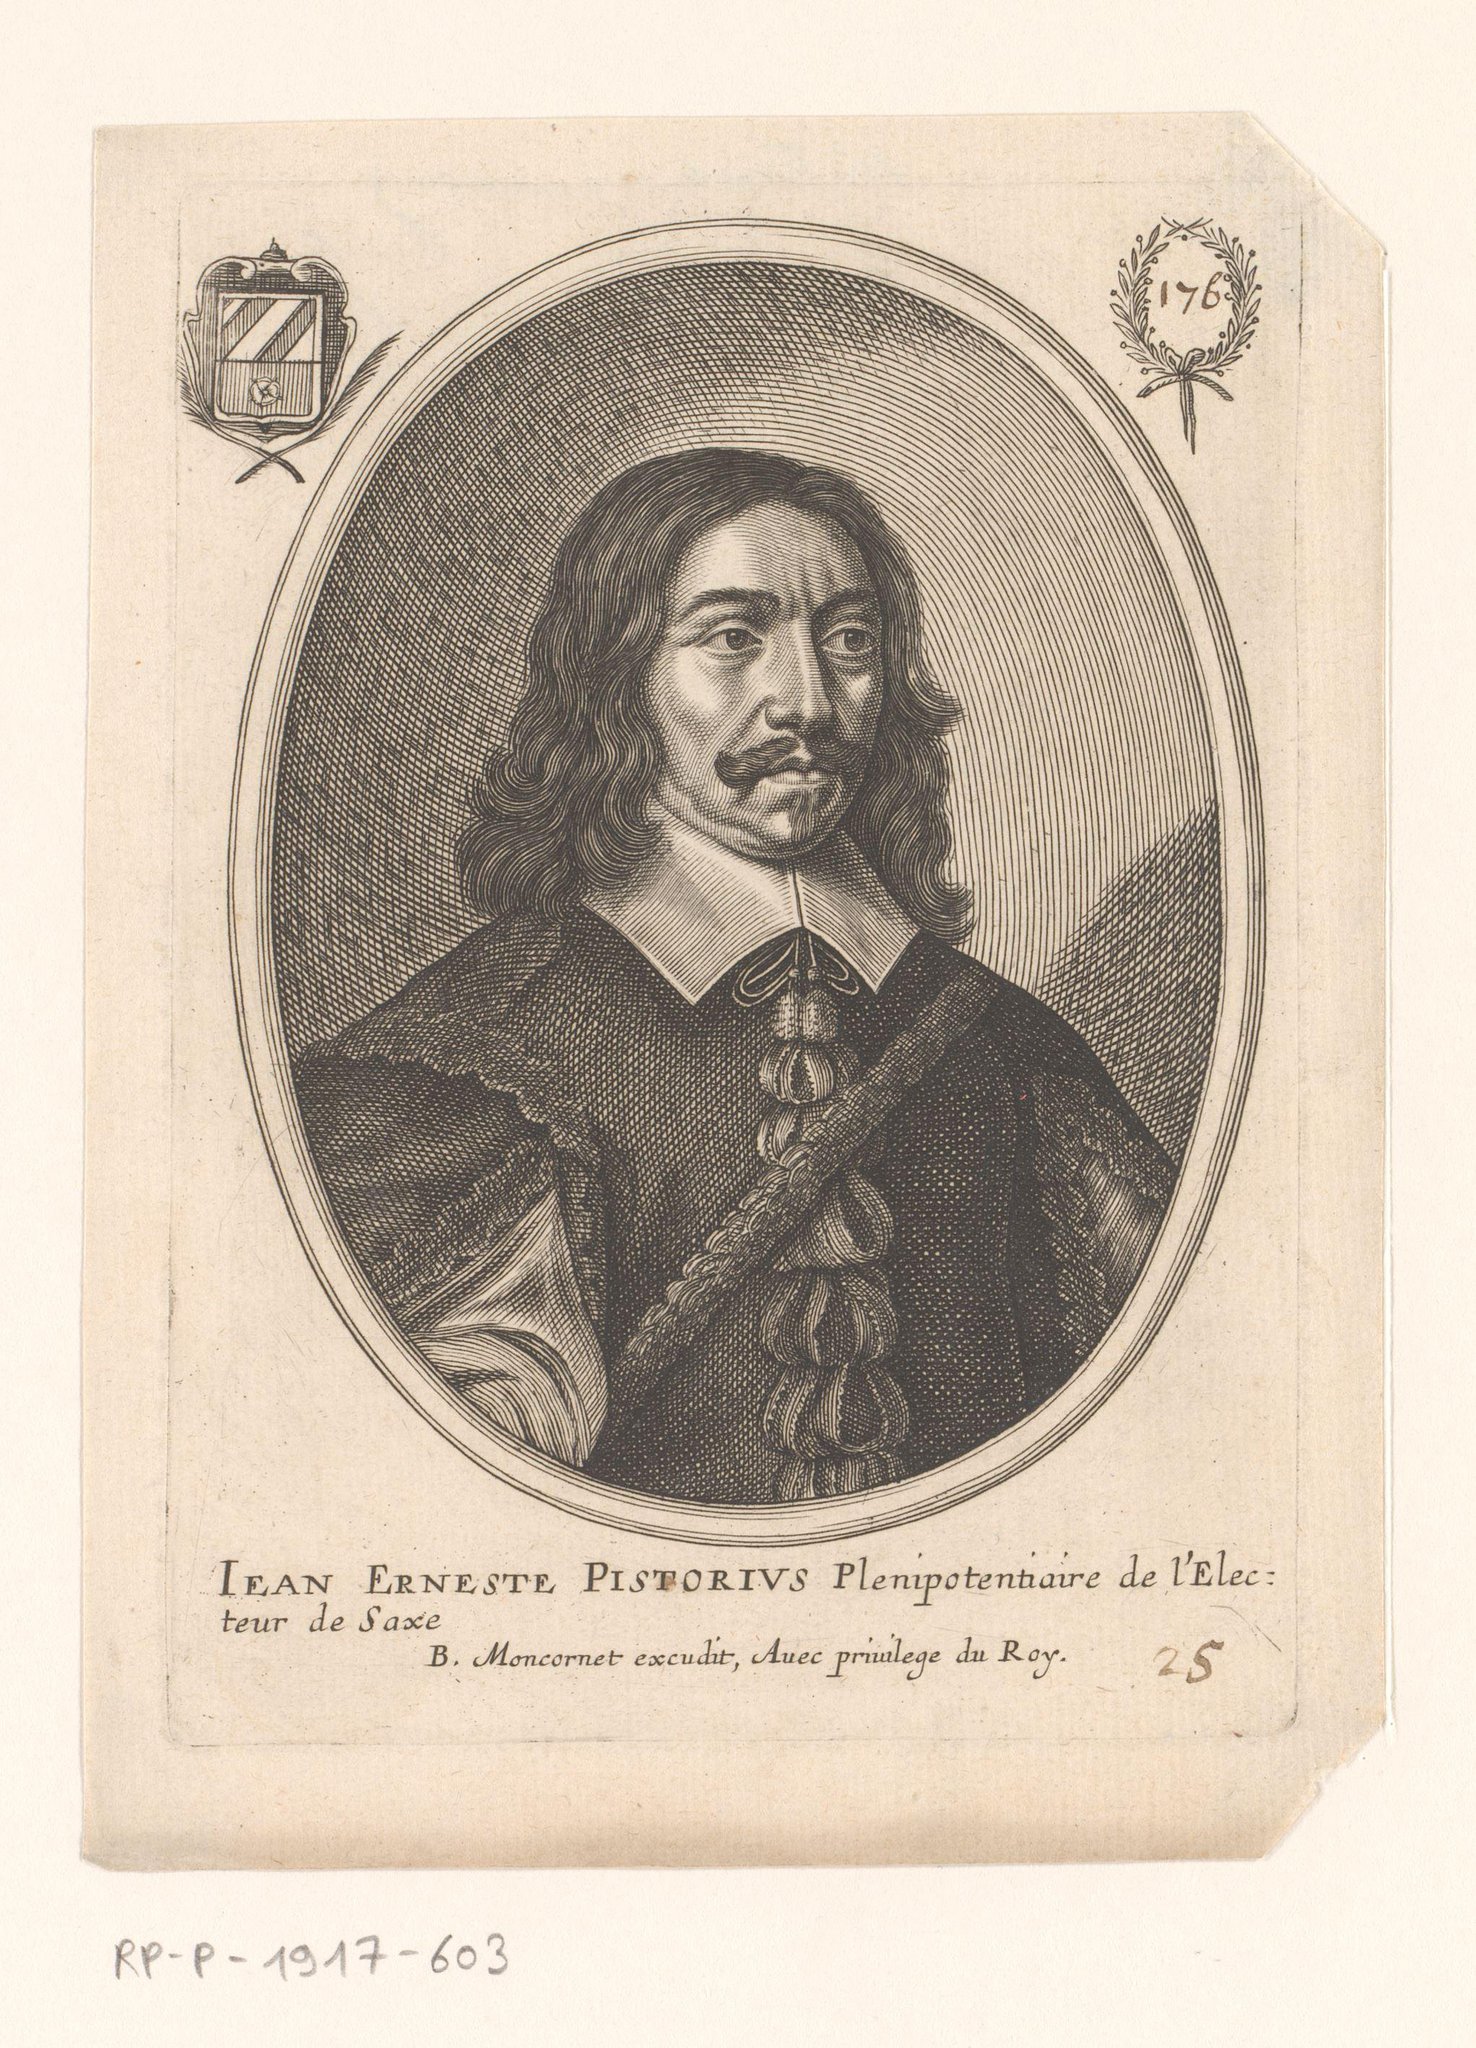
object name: print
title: Portret van Johann Ernst von Pistorius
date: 1648-1668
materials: paper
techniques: engraving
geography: france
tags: historical persons, ambassador, armorial bearing, heraldry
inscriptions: number: ‘176’, number: ‘45’, inscription: ‘in Franken aanwezig/ Gm’, number: ‘25’, collector's mark: Lugt 2228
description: In een ovaal met linksboven een wapenschild en rechtsboven een lauwerkrans.